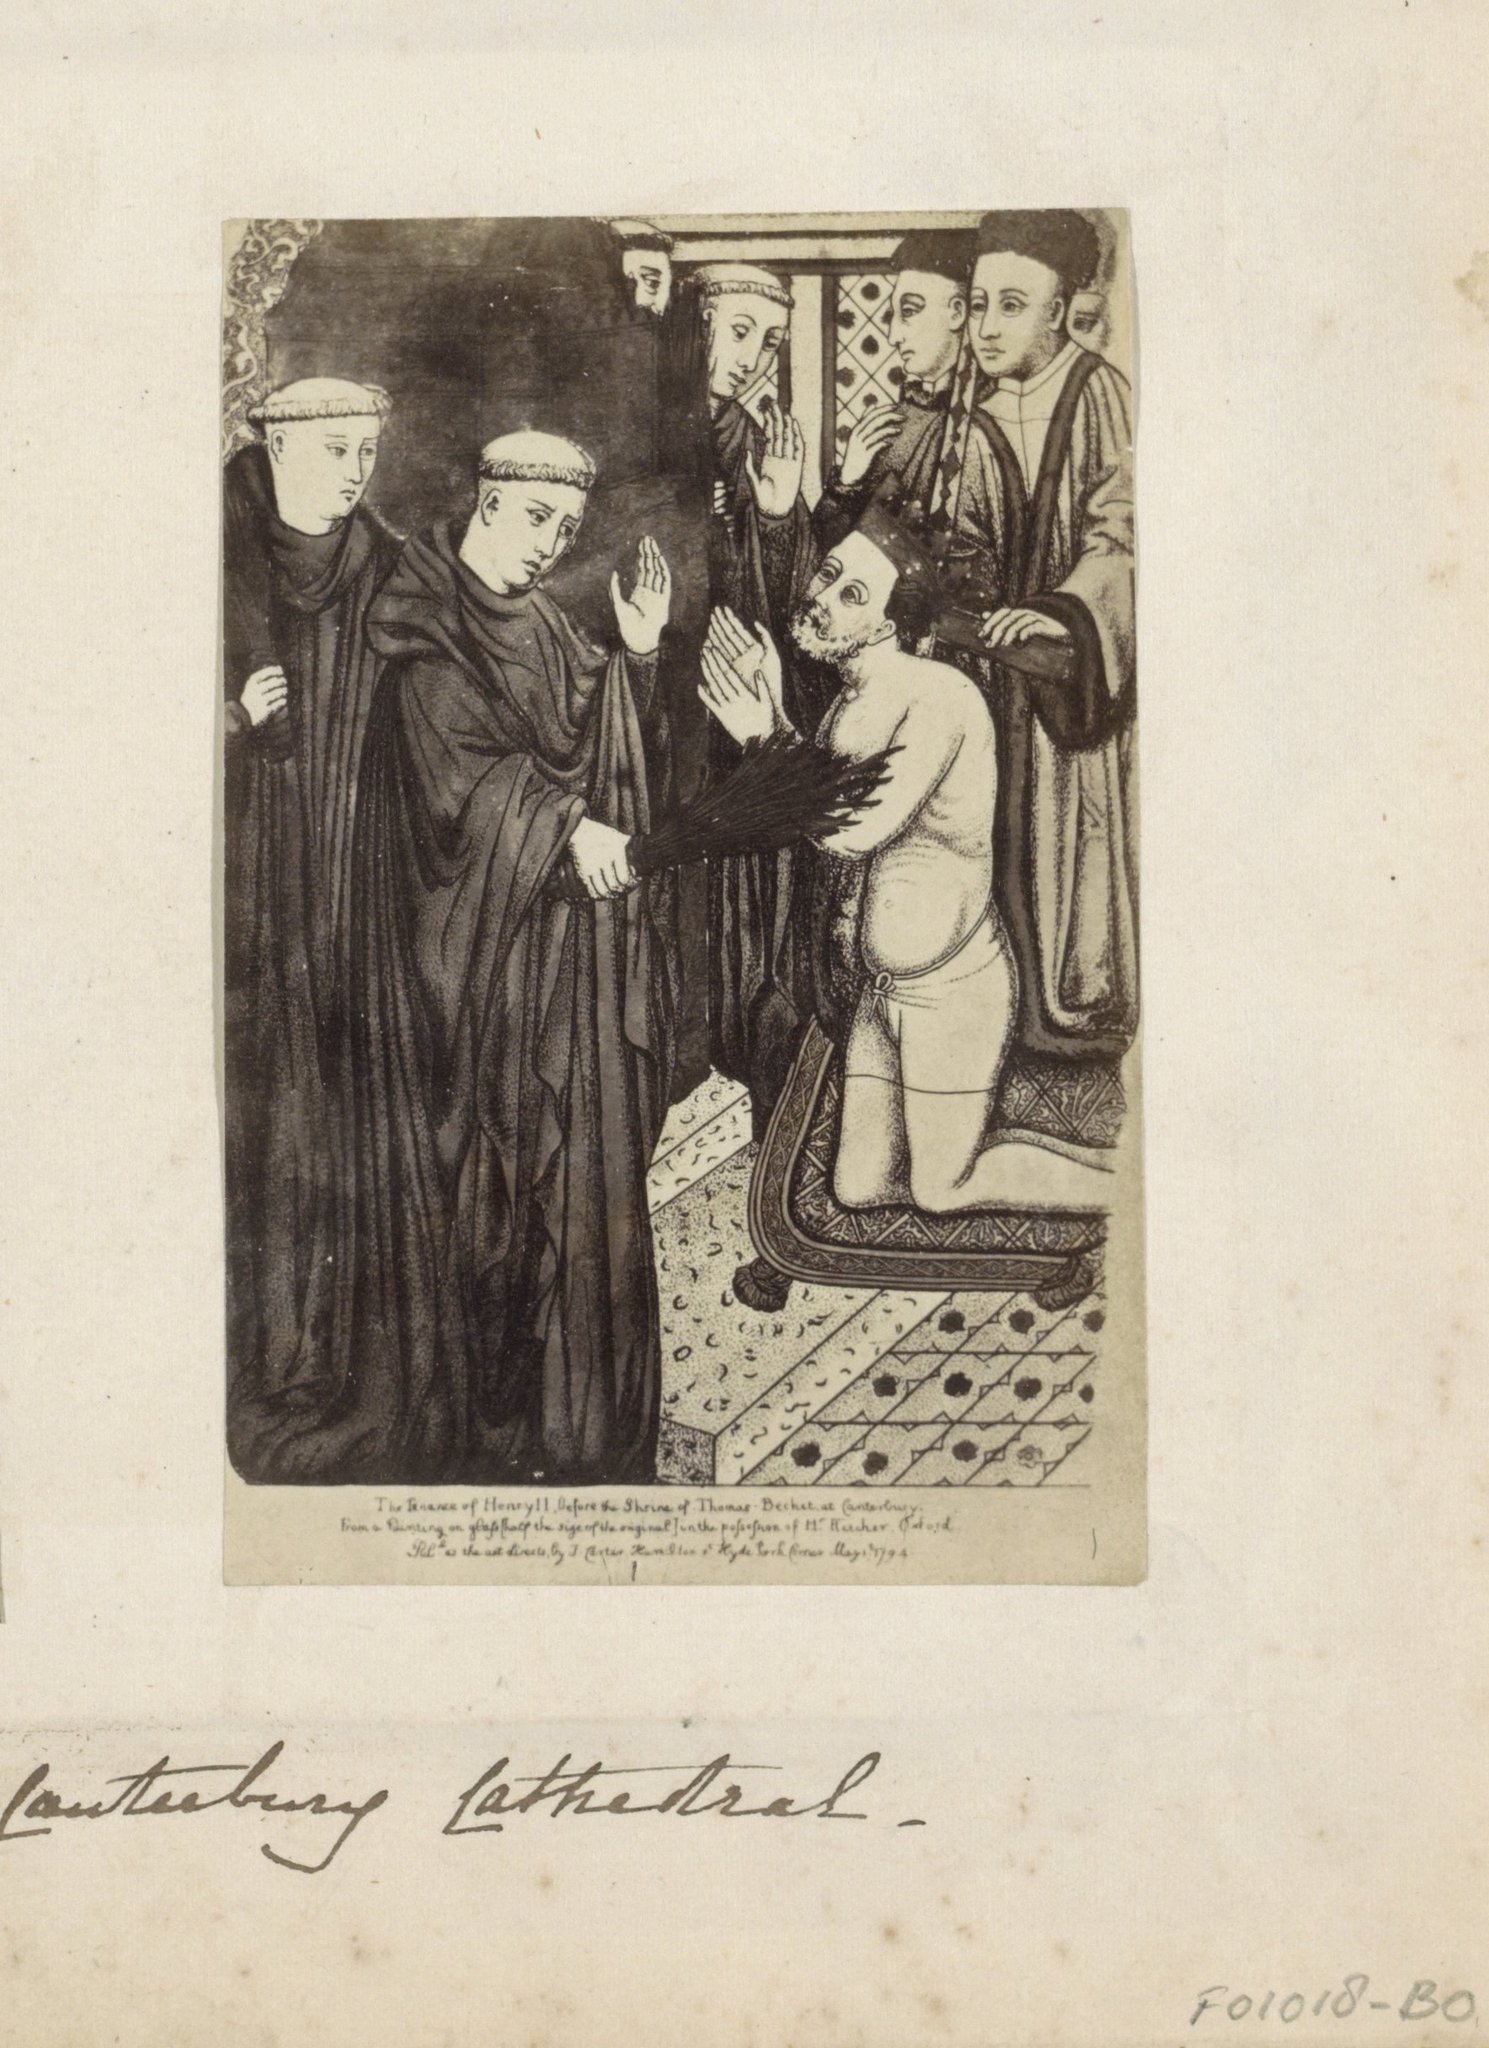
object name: reproduction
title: Fotoreproductie van een schildering uit de kathedraal van Canterbury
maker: Anonymous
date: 1860-1870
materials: paper, photographic support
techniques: albumen print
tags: martyrdom, suffering, misfortune, death of st. thomas becket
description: Afgebeeld is de moord op de Engelse aartsbisschop Thomas Becket in de kathedraal van Canterbury in 1170. Onderdeel van Engels familiealbum met foto's van personen, reizen, cricket en kunstwerken.